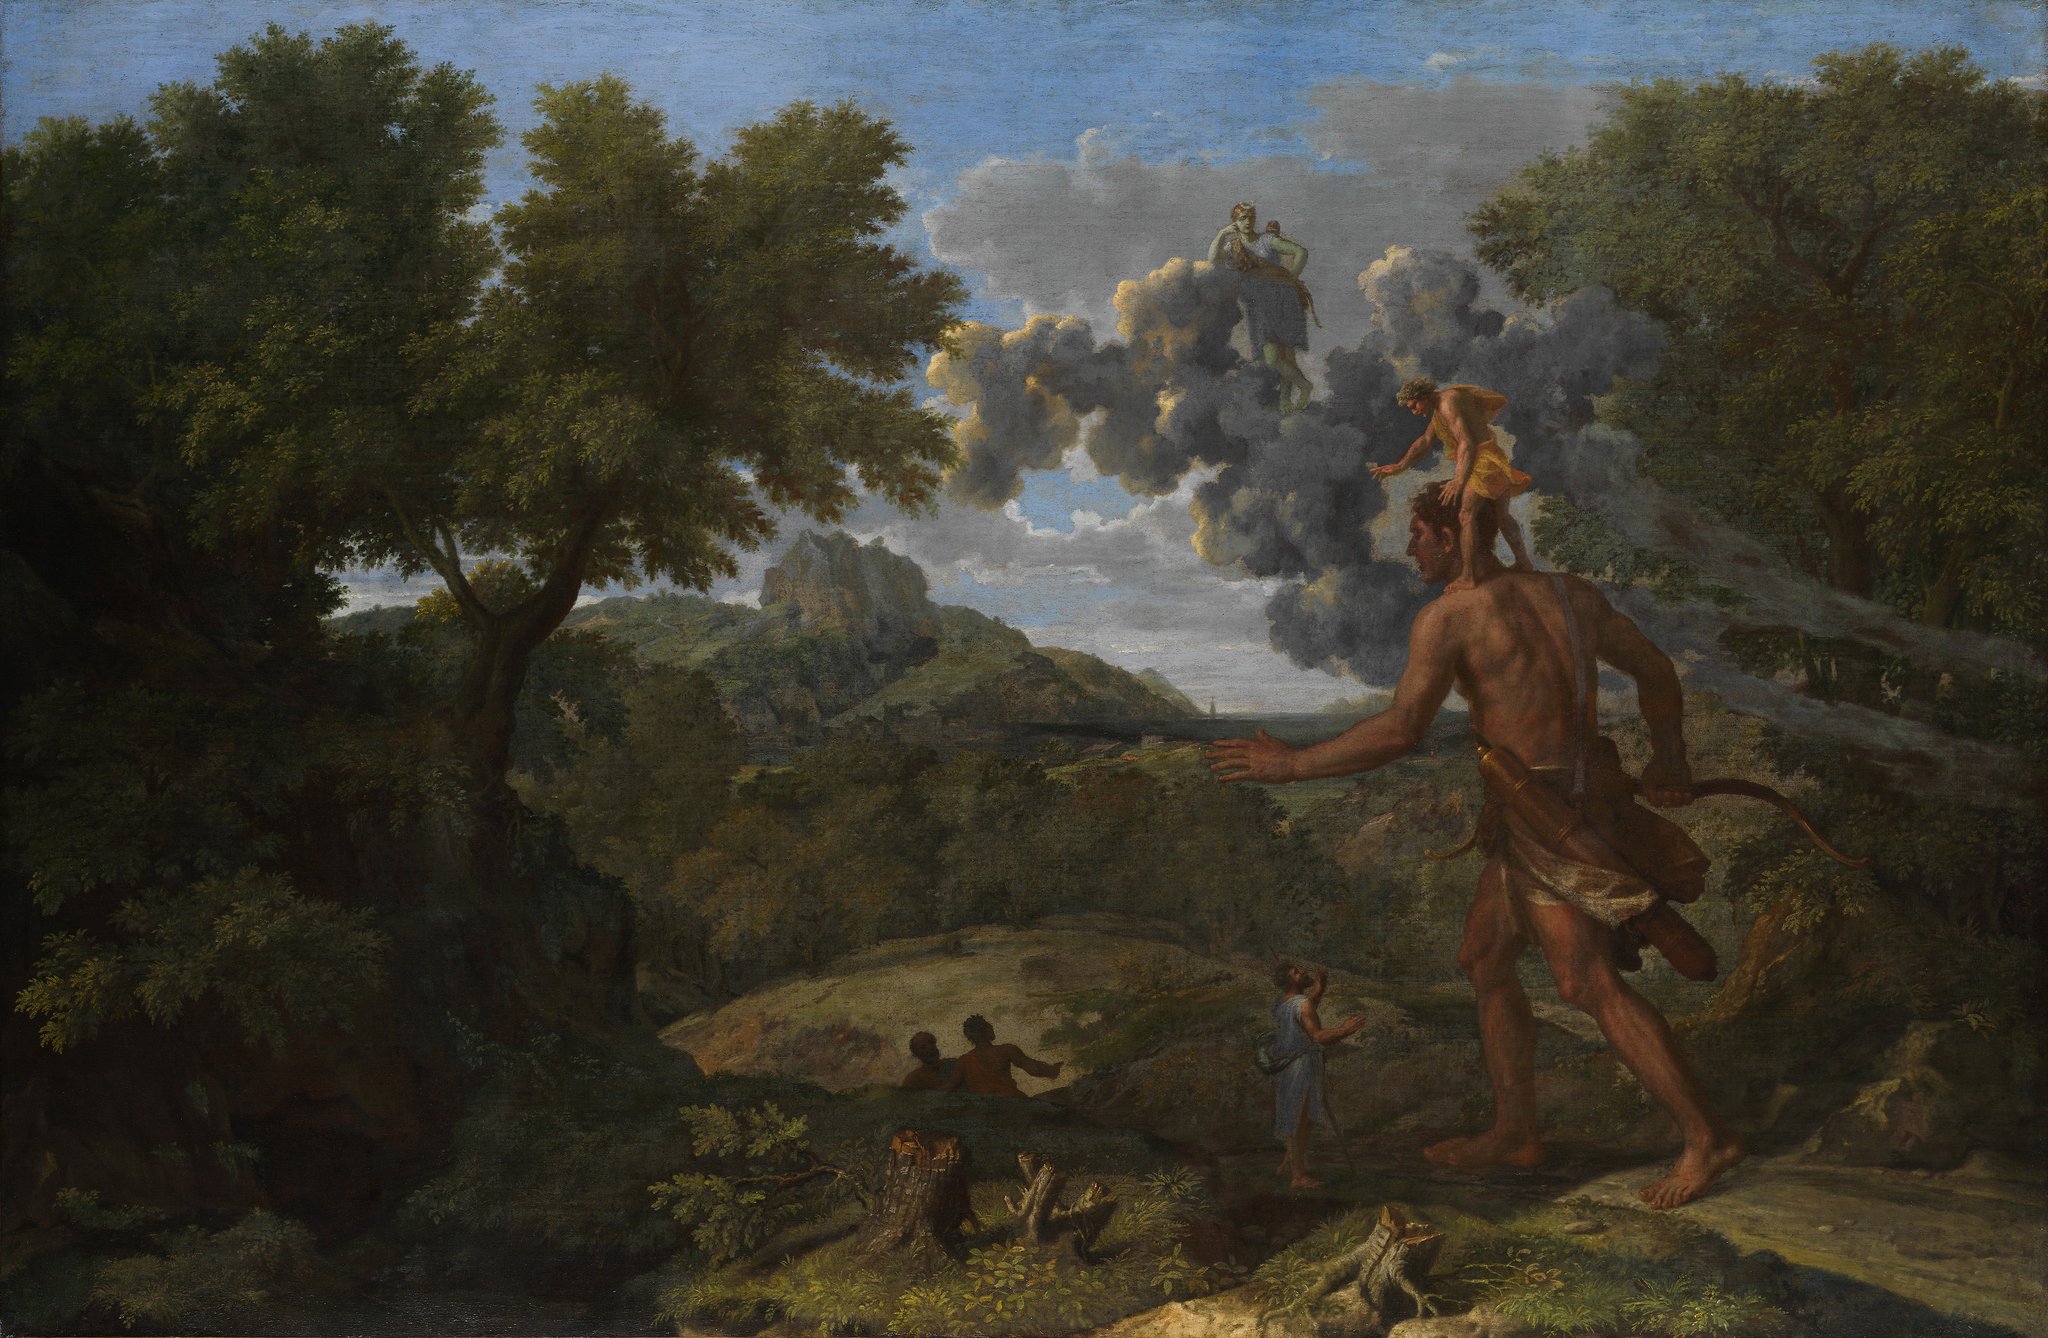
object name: painting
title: Blind Orion Searching for the Rising Sun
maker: nicolas poussin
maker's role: artist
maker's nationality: french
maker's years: 1594-1665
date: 1658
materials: canvas, oil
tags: orion,diana,landscapes